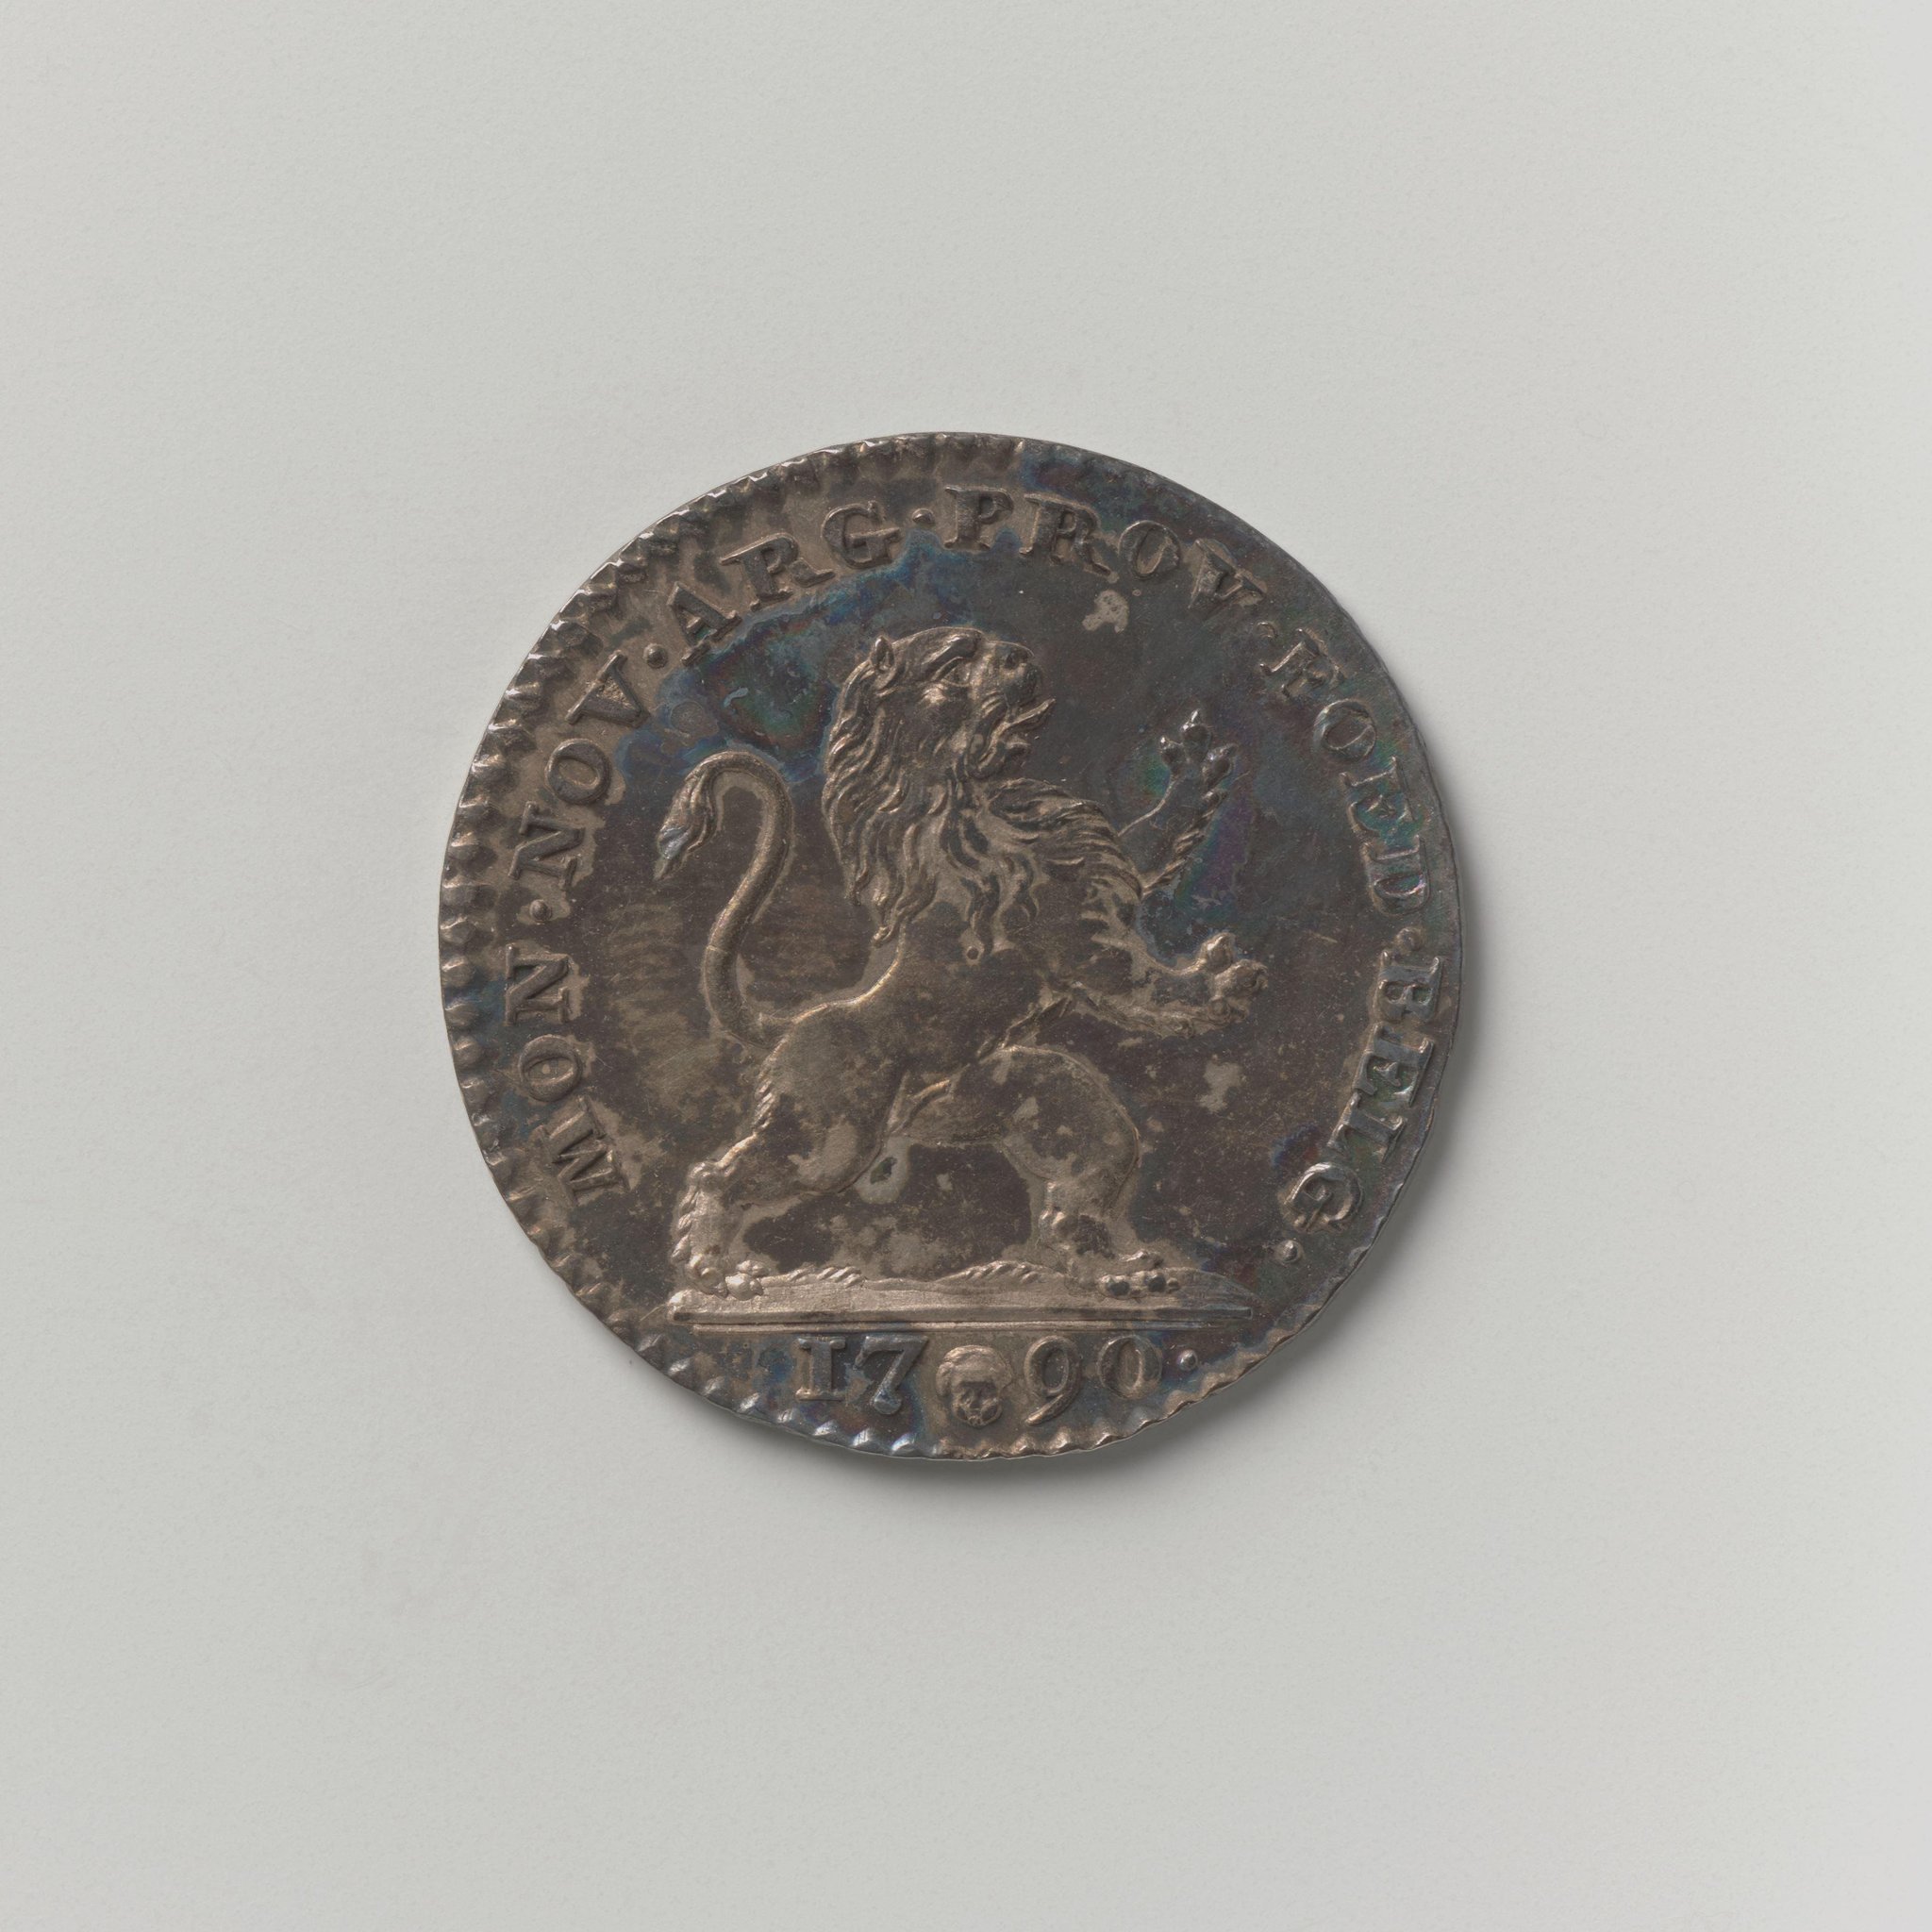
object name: coin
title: Verenigde Belgische Staten, 10 stuiver, 1790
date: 1790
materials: silver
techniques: striking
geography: brussels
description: Zilveren munt. Voorzijde: staande leeuw naar rechts. Jaartal, waartussen engelenkop, in afsnede. Keerzijde: twee uit wolken komende ineengeslagen handen, waarin pijlenbundel. In afsnede waarde-aanduiding. Omschrift: IN VNIONE SALVS. Kabelrand.